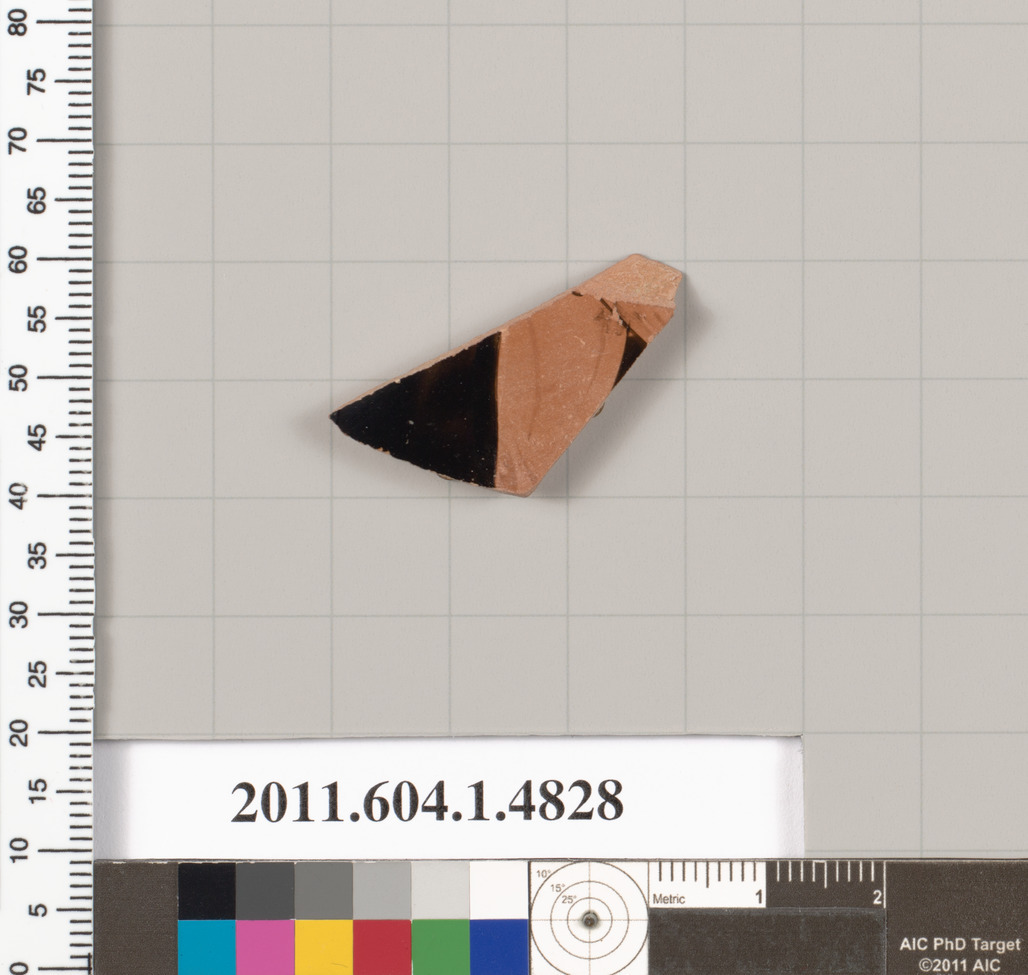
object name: kylix fragment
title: Terracotta fragment of a kylix (drinking cup)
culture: greek, attic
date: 490-470 BCE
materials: terracotta